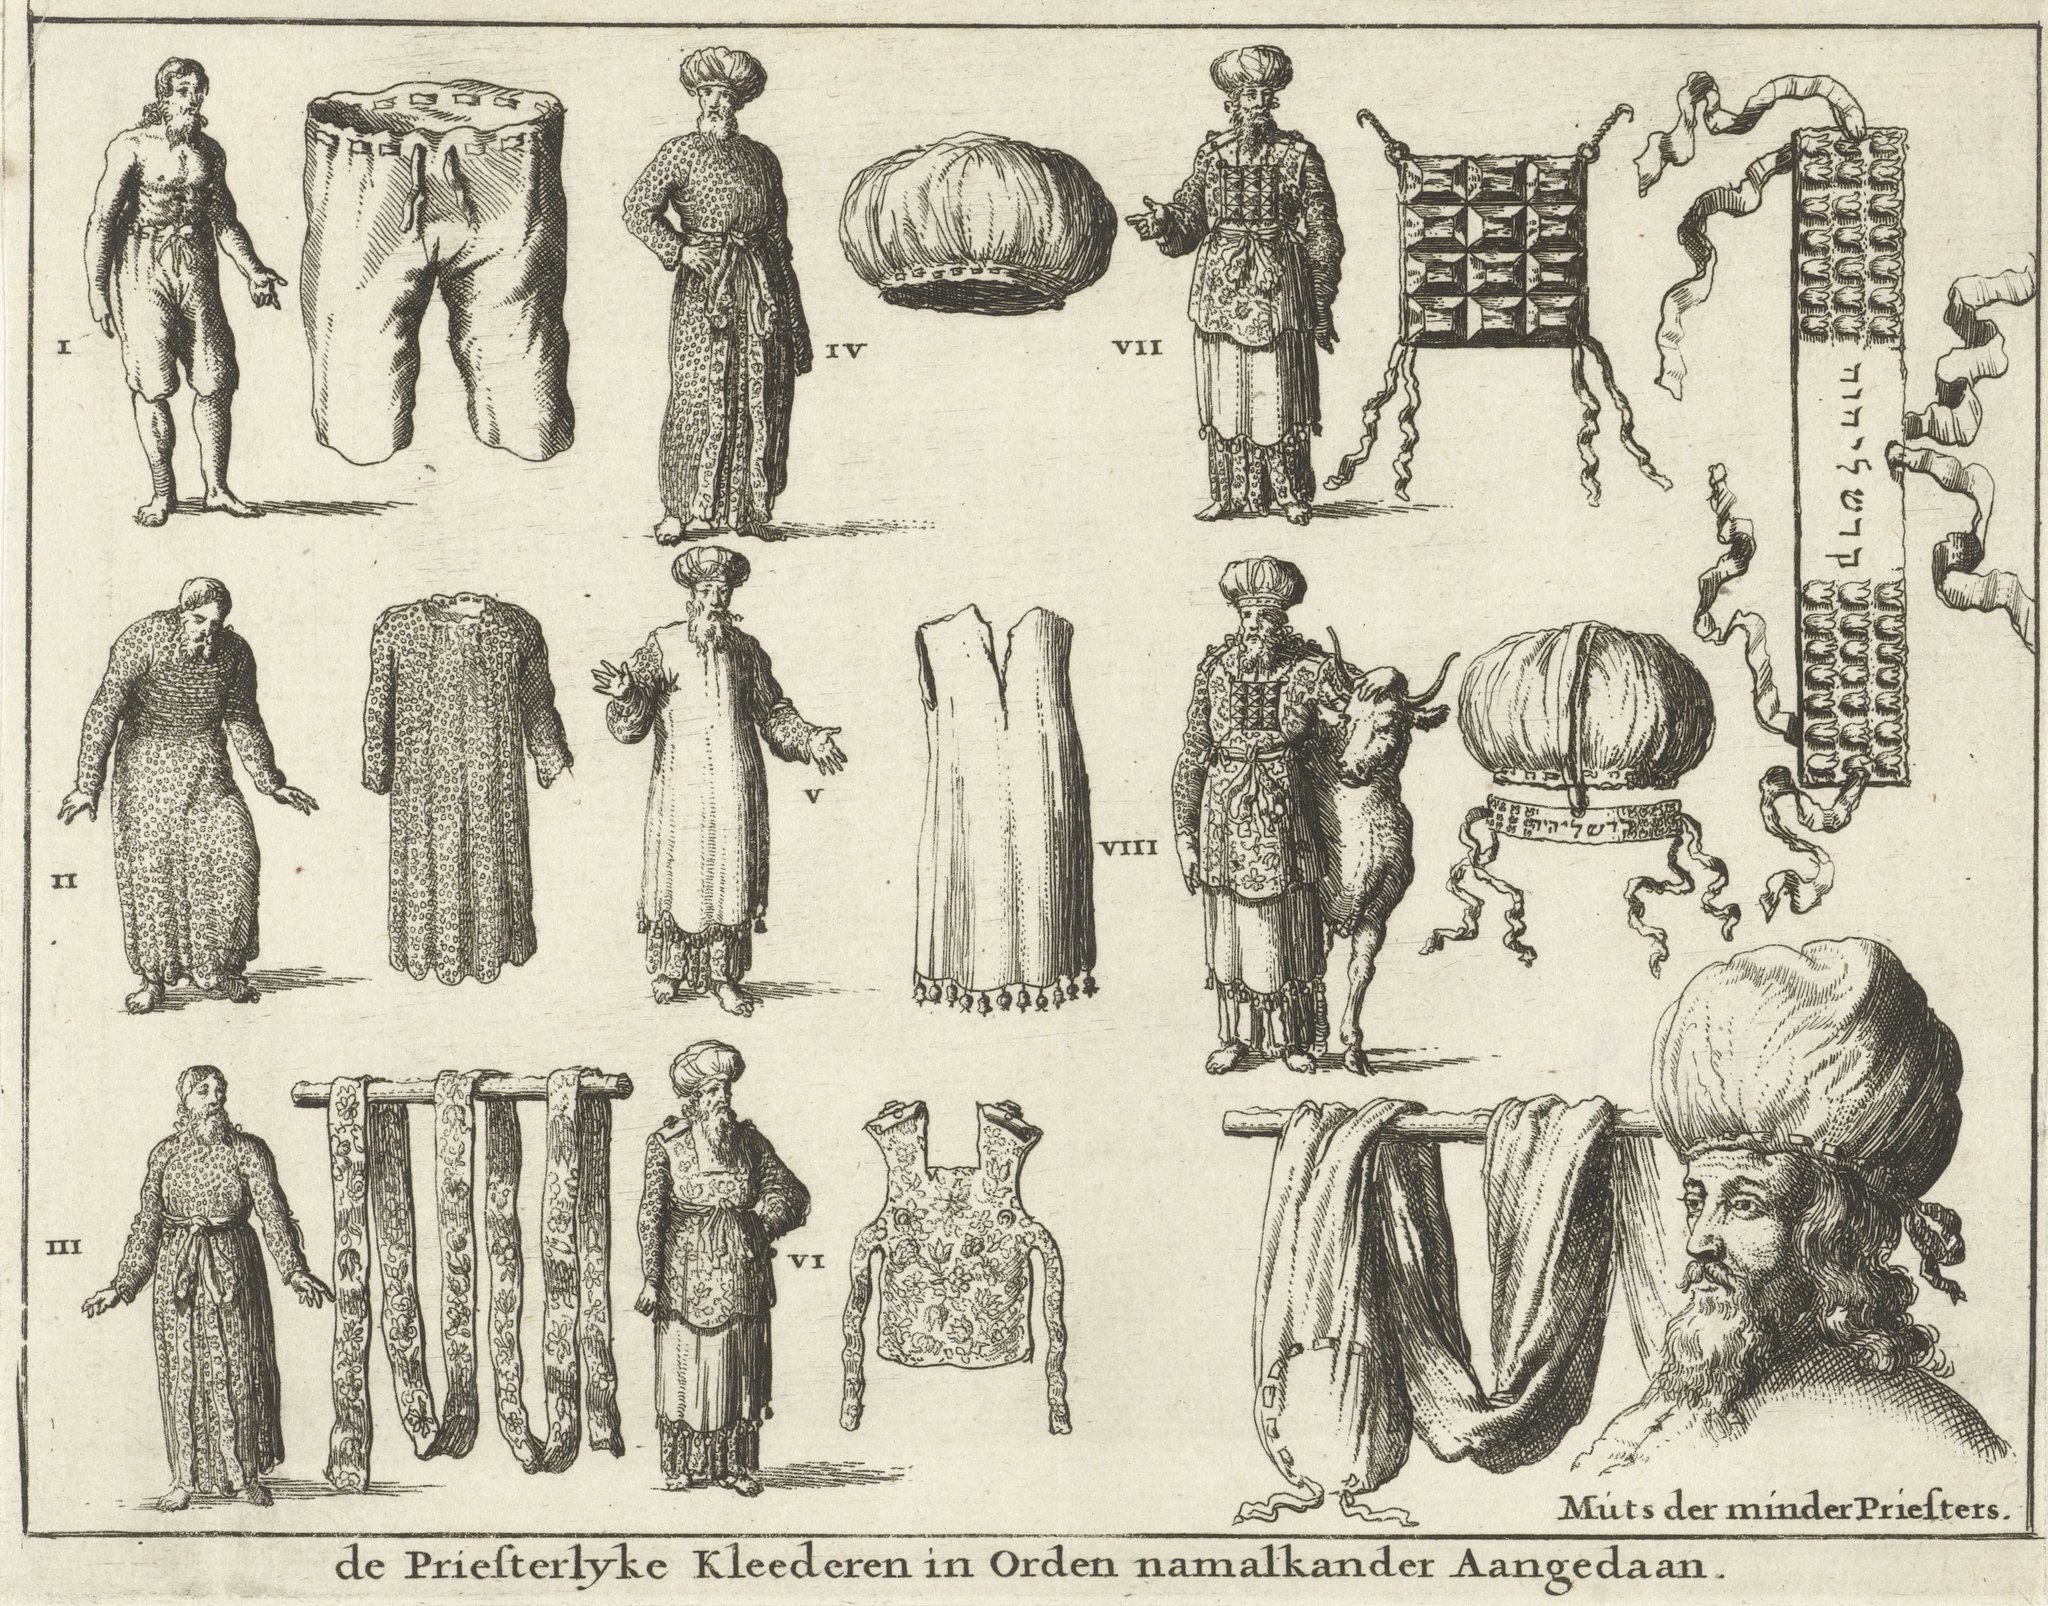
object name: print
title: De Priesterlyke Kleederen in Orden namalkander Aangedaan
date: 1682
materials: paper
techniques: etching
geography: amsterdam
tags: high priest ~ hierarchy of priests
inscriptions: collector's mark: Lugt 2228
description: Illustratie opgenomen in: Cunaeus, Petrus. De republyk der Hebreen, of gemeenebest der joden, 3 delen. Amsterdam: Wilhelmus Goeree, 1682, dl. 1, p. 170.